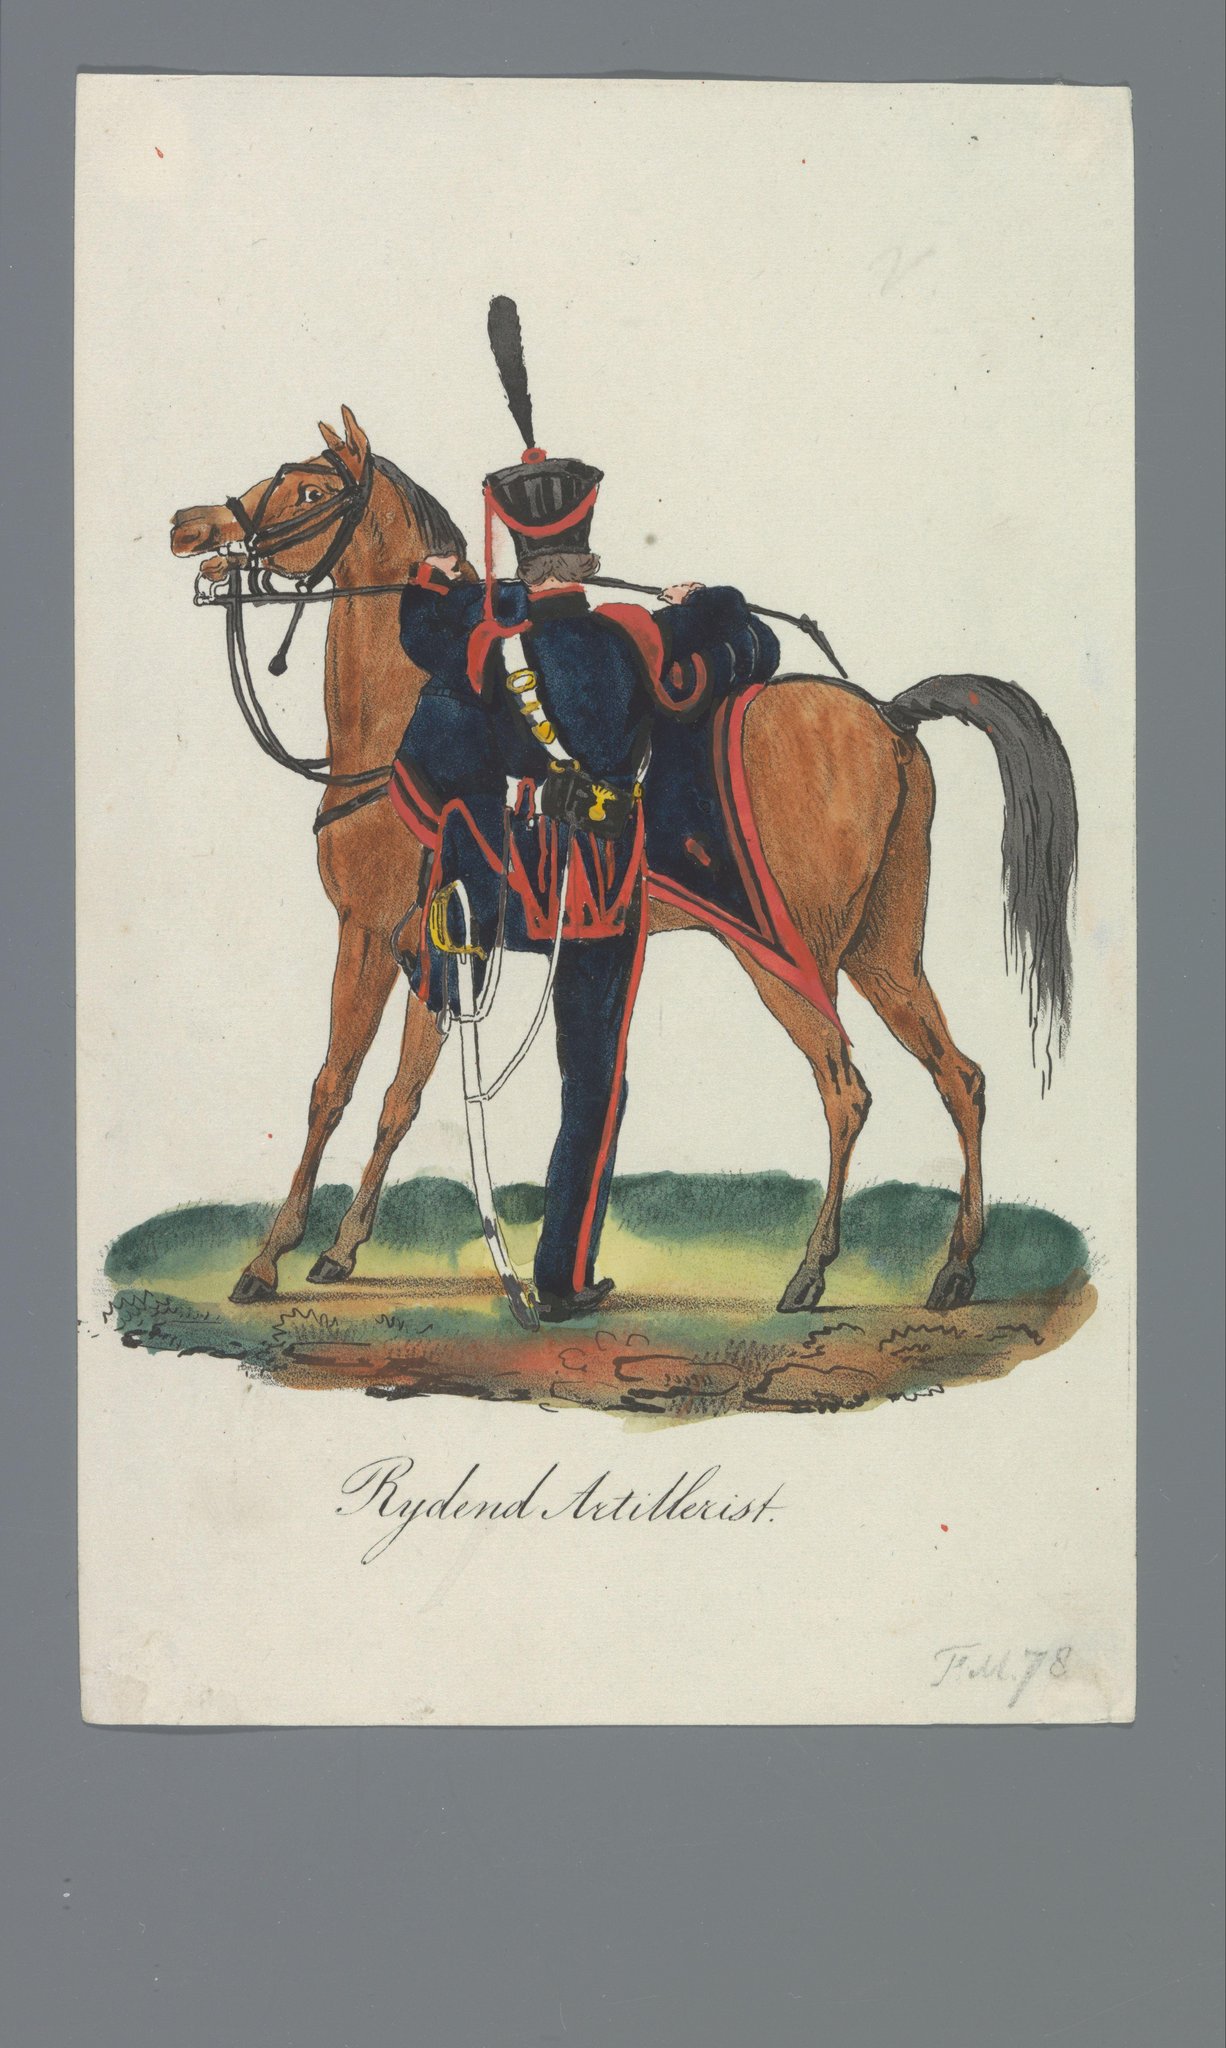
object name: print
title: Nederlandse militaire uniformen in de jaren 1830-1832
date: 1835-1850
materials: paper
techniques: hand coloring, lithograph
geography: utrecht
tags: (military) uniforms, clothes, costume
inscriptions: collector's mark: Lugt 2228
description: Artillerist van de Rijdende Artillerie, bezig op zijn paard te stijgen. Onderdeel van een serie van 157 losse bladen met Nederlandse militaire uniformen in de jaren 1830-1832.